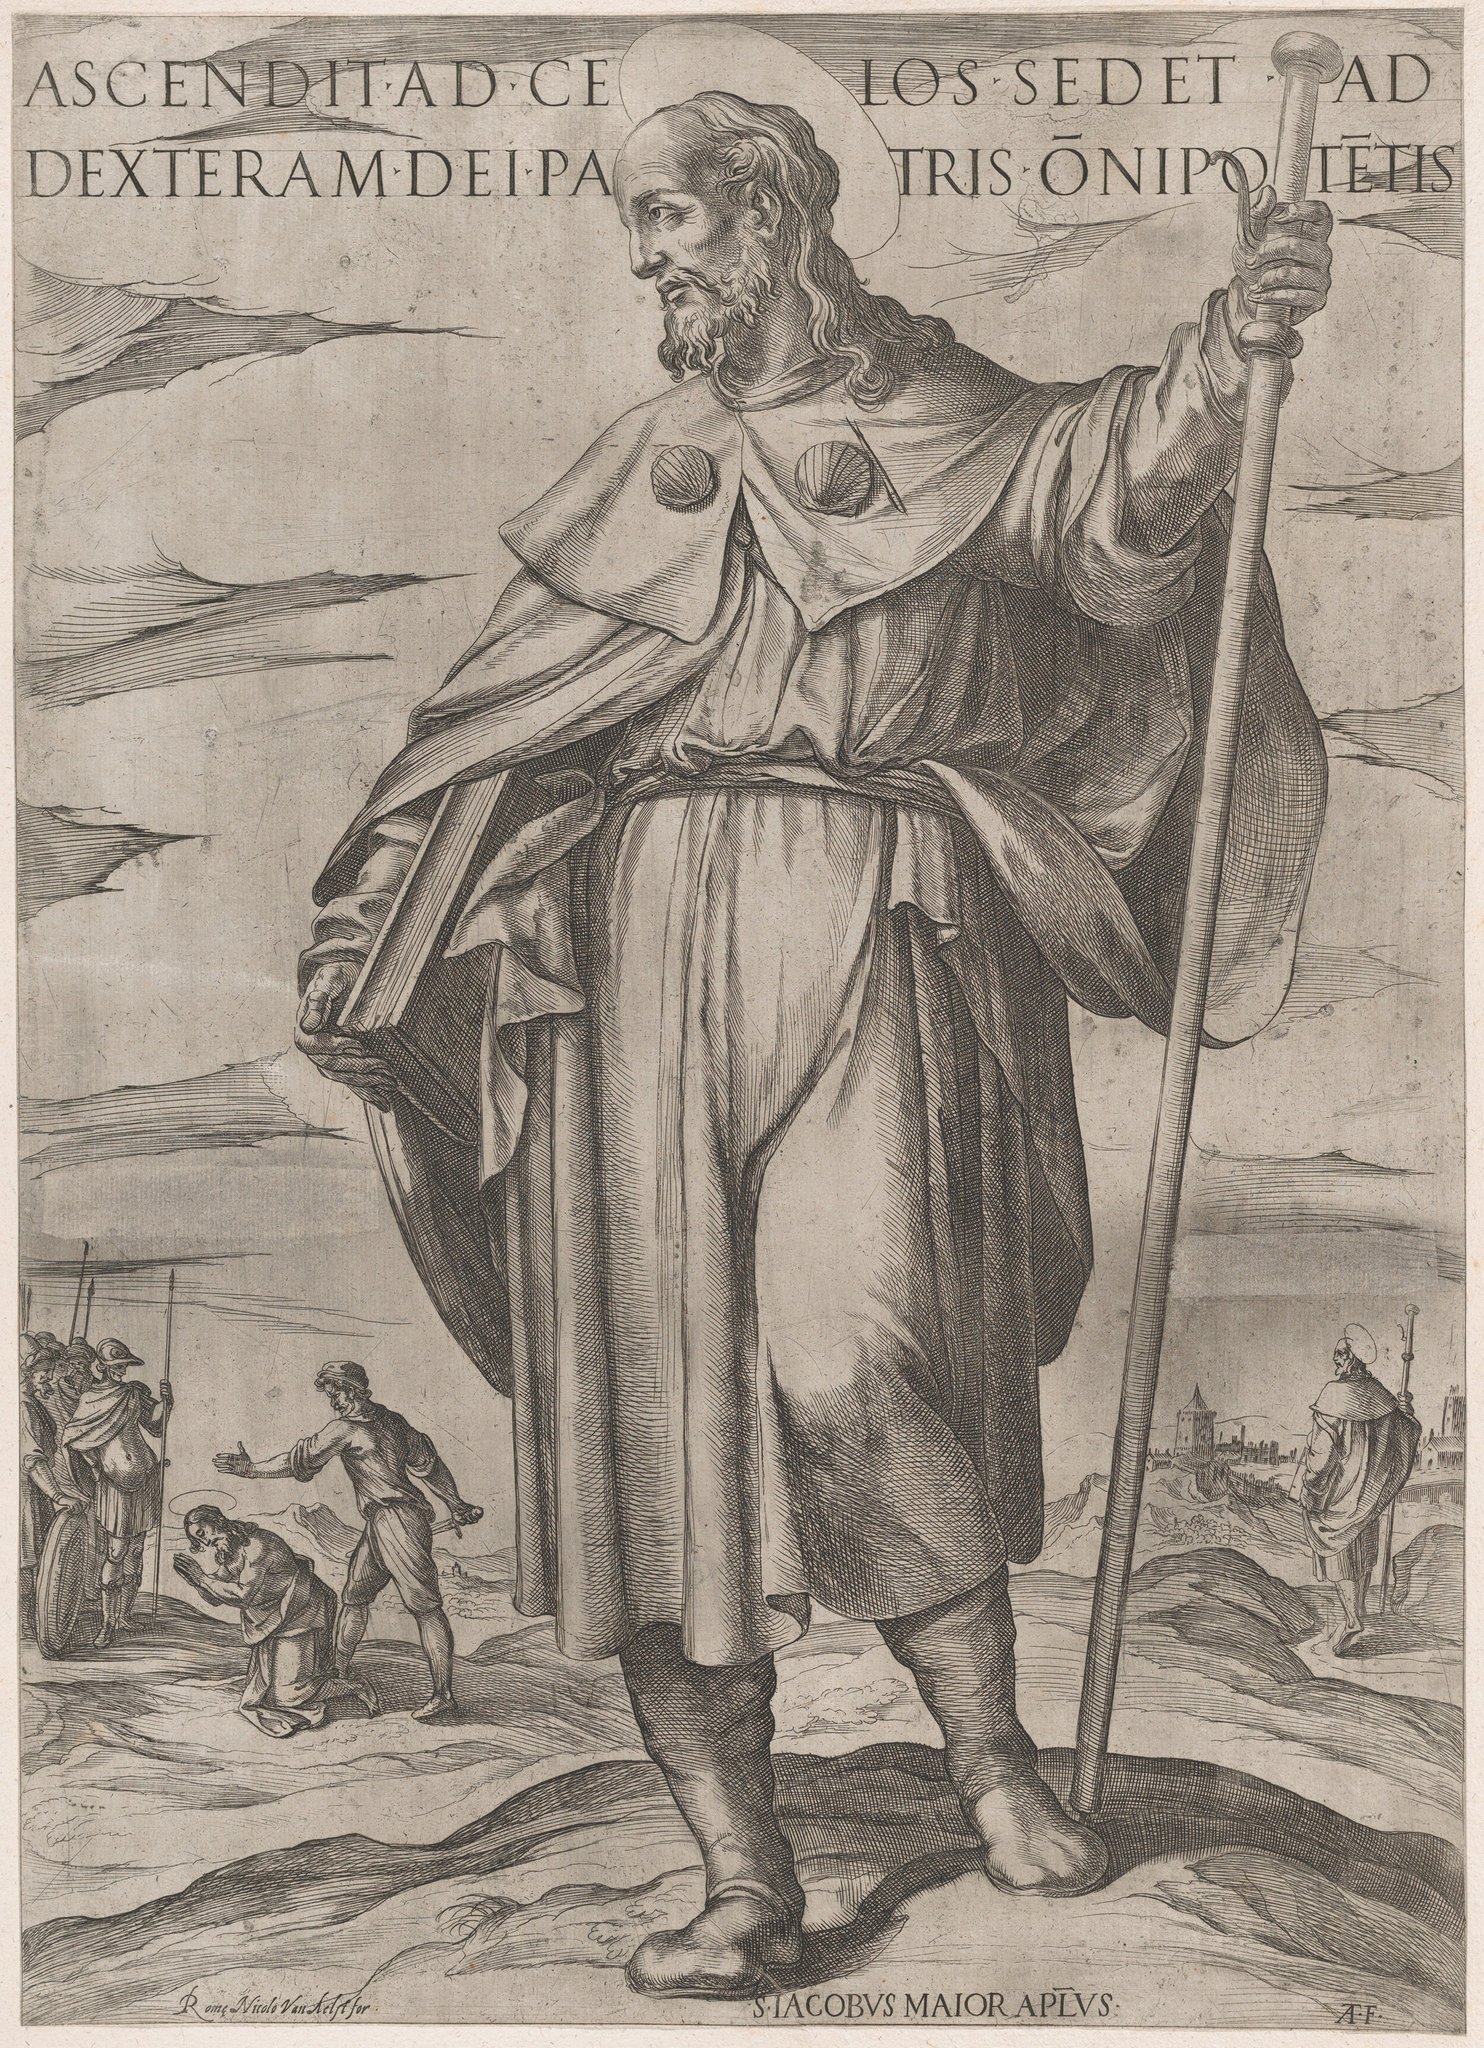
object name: print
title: St. James Major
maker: antonio tempesta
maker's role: artist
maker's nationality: italian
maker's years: 1555-1630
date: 1567-1600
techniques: etching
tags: saints